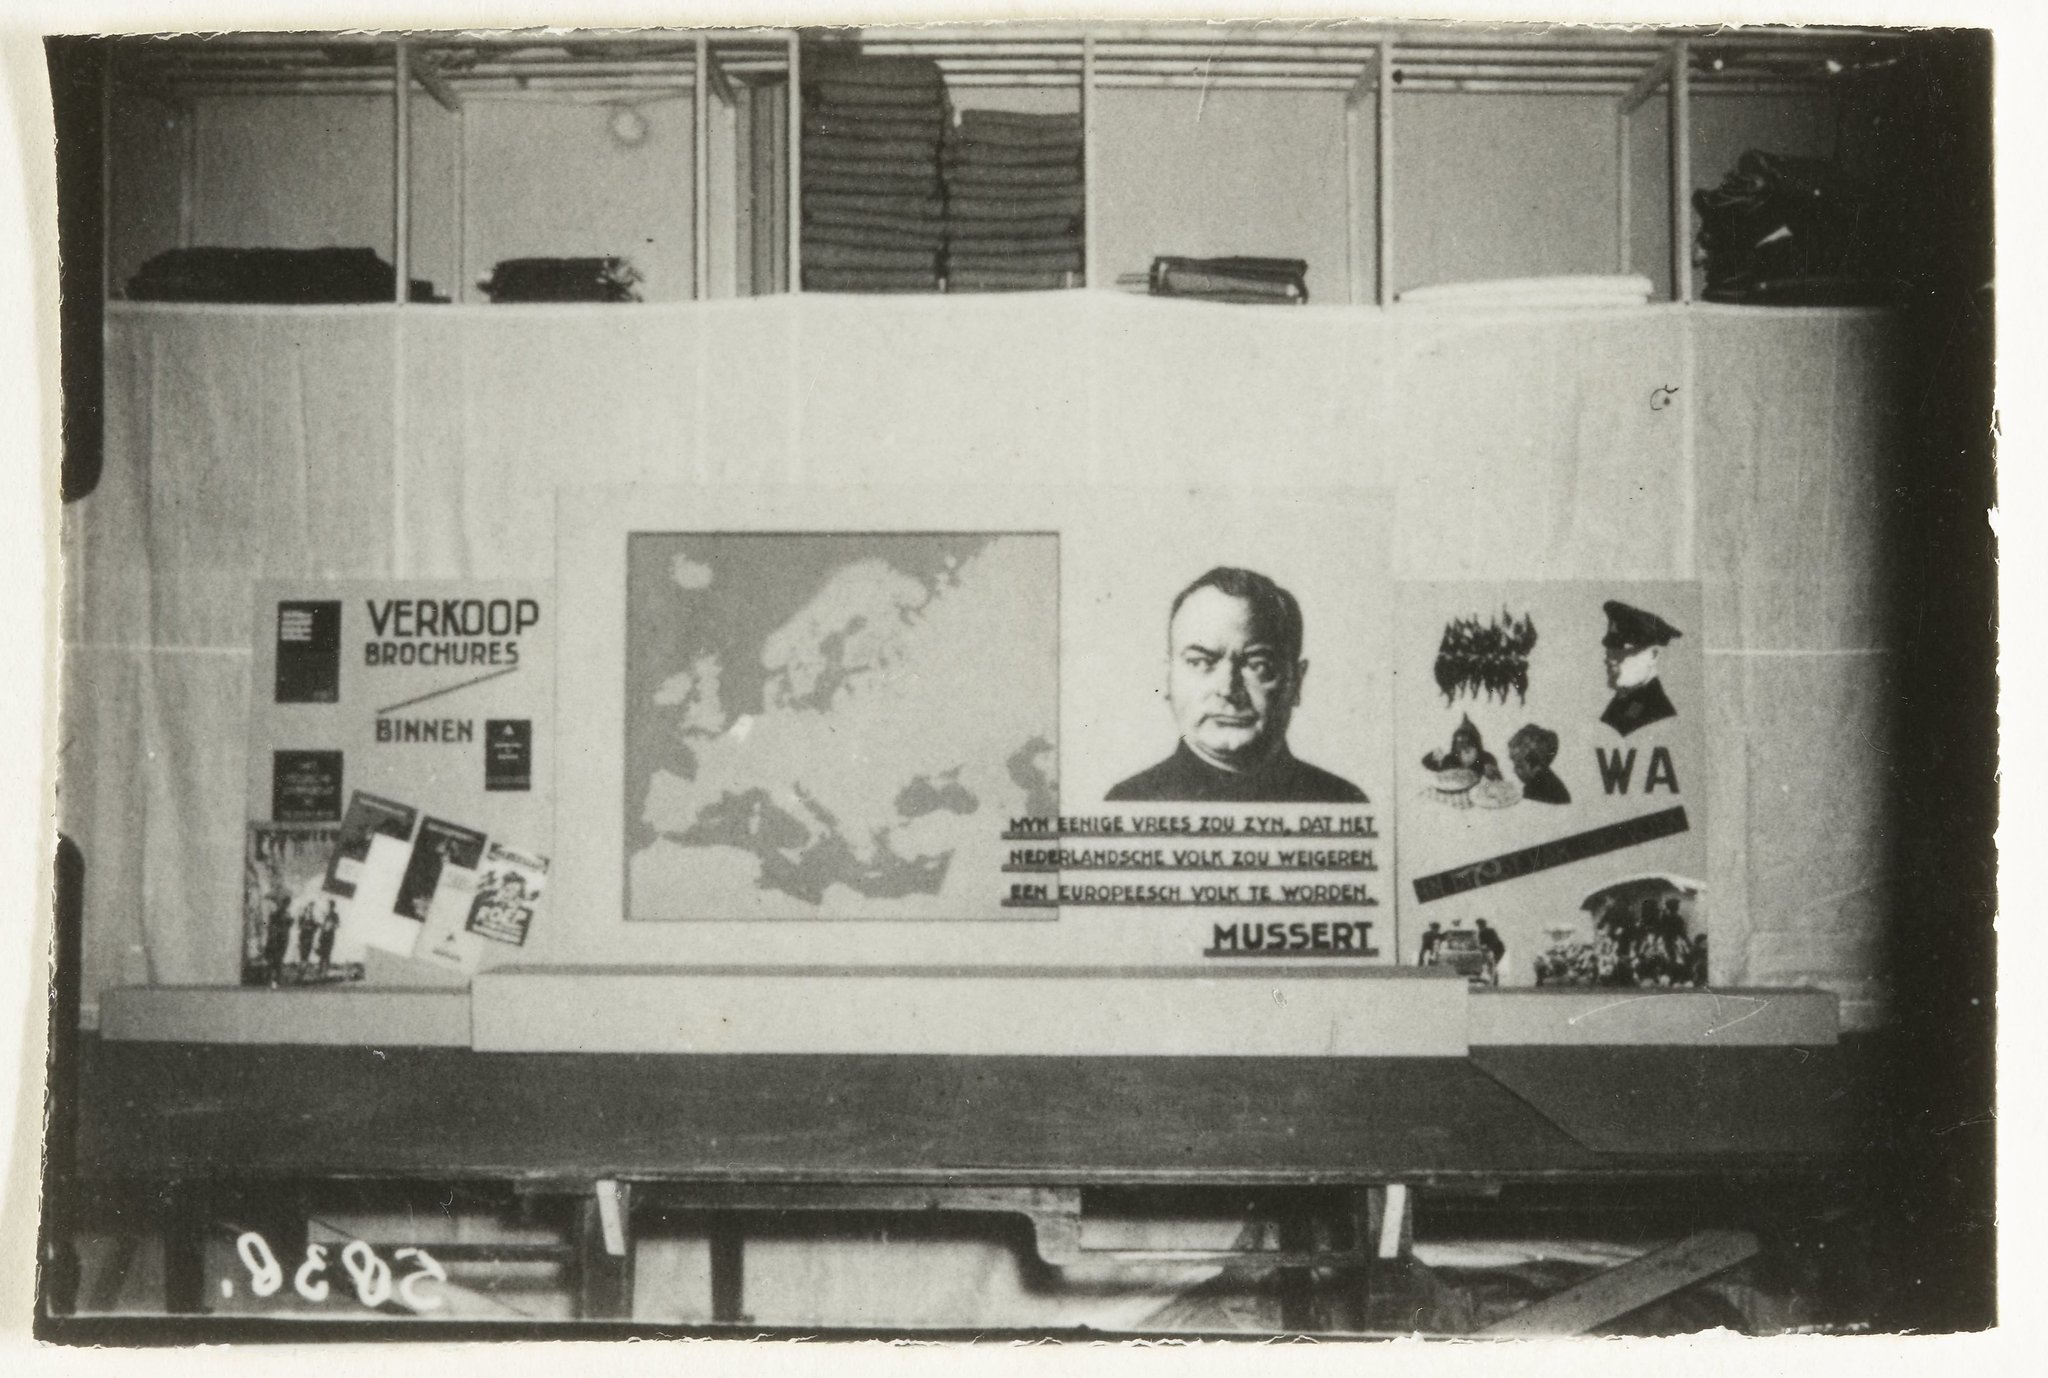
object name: contact print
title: NSB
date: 1940-1944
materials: photographic support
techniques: photography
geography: netherlands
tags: political propaganda, netherlands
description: Een etalage met reclame en propaganda materiaal van de NSB. Duidelijk te zien zijn een kaart van Europa en een portret van Mussert en de mededeling: Verkoop brochures binnen.